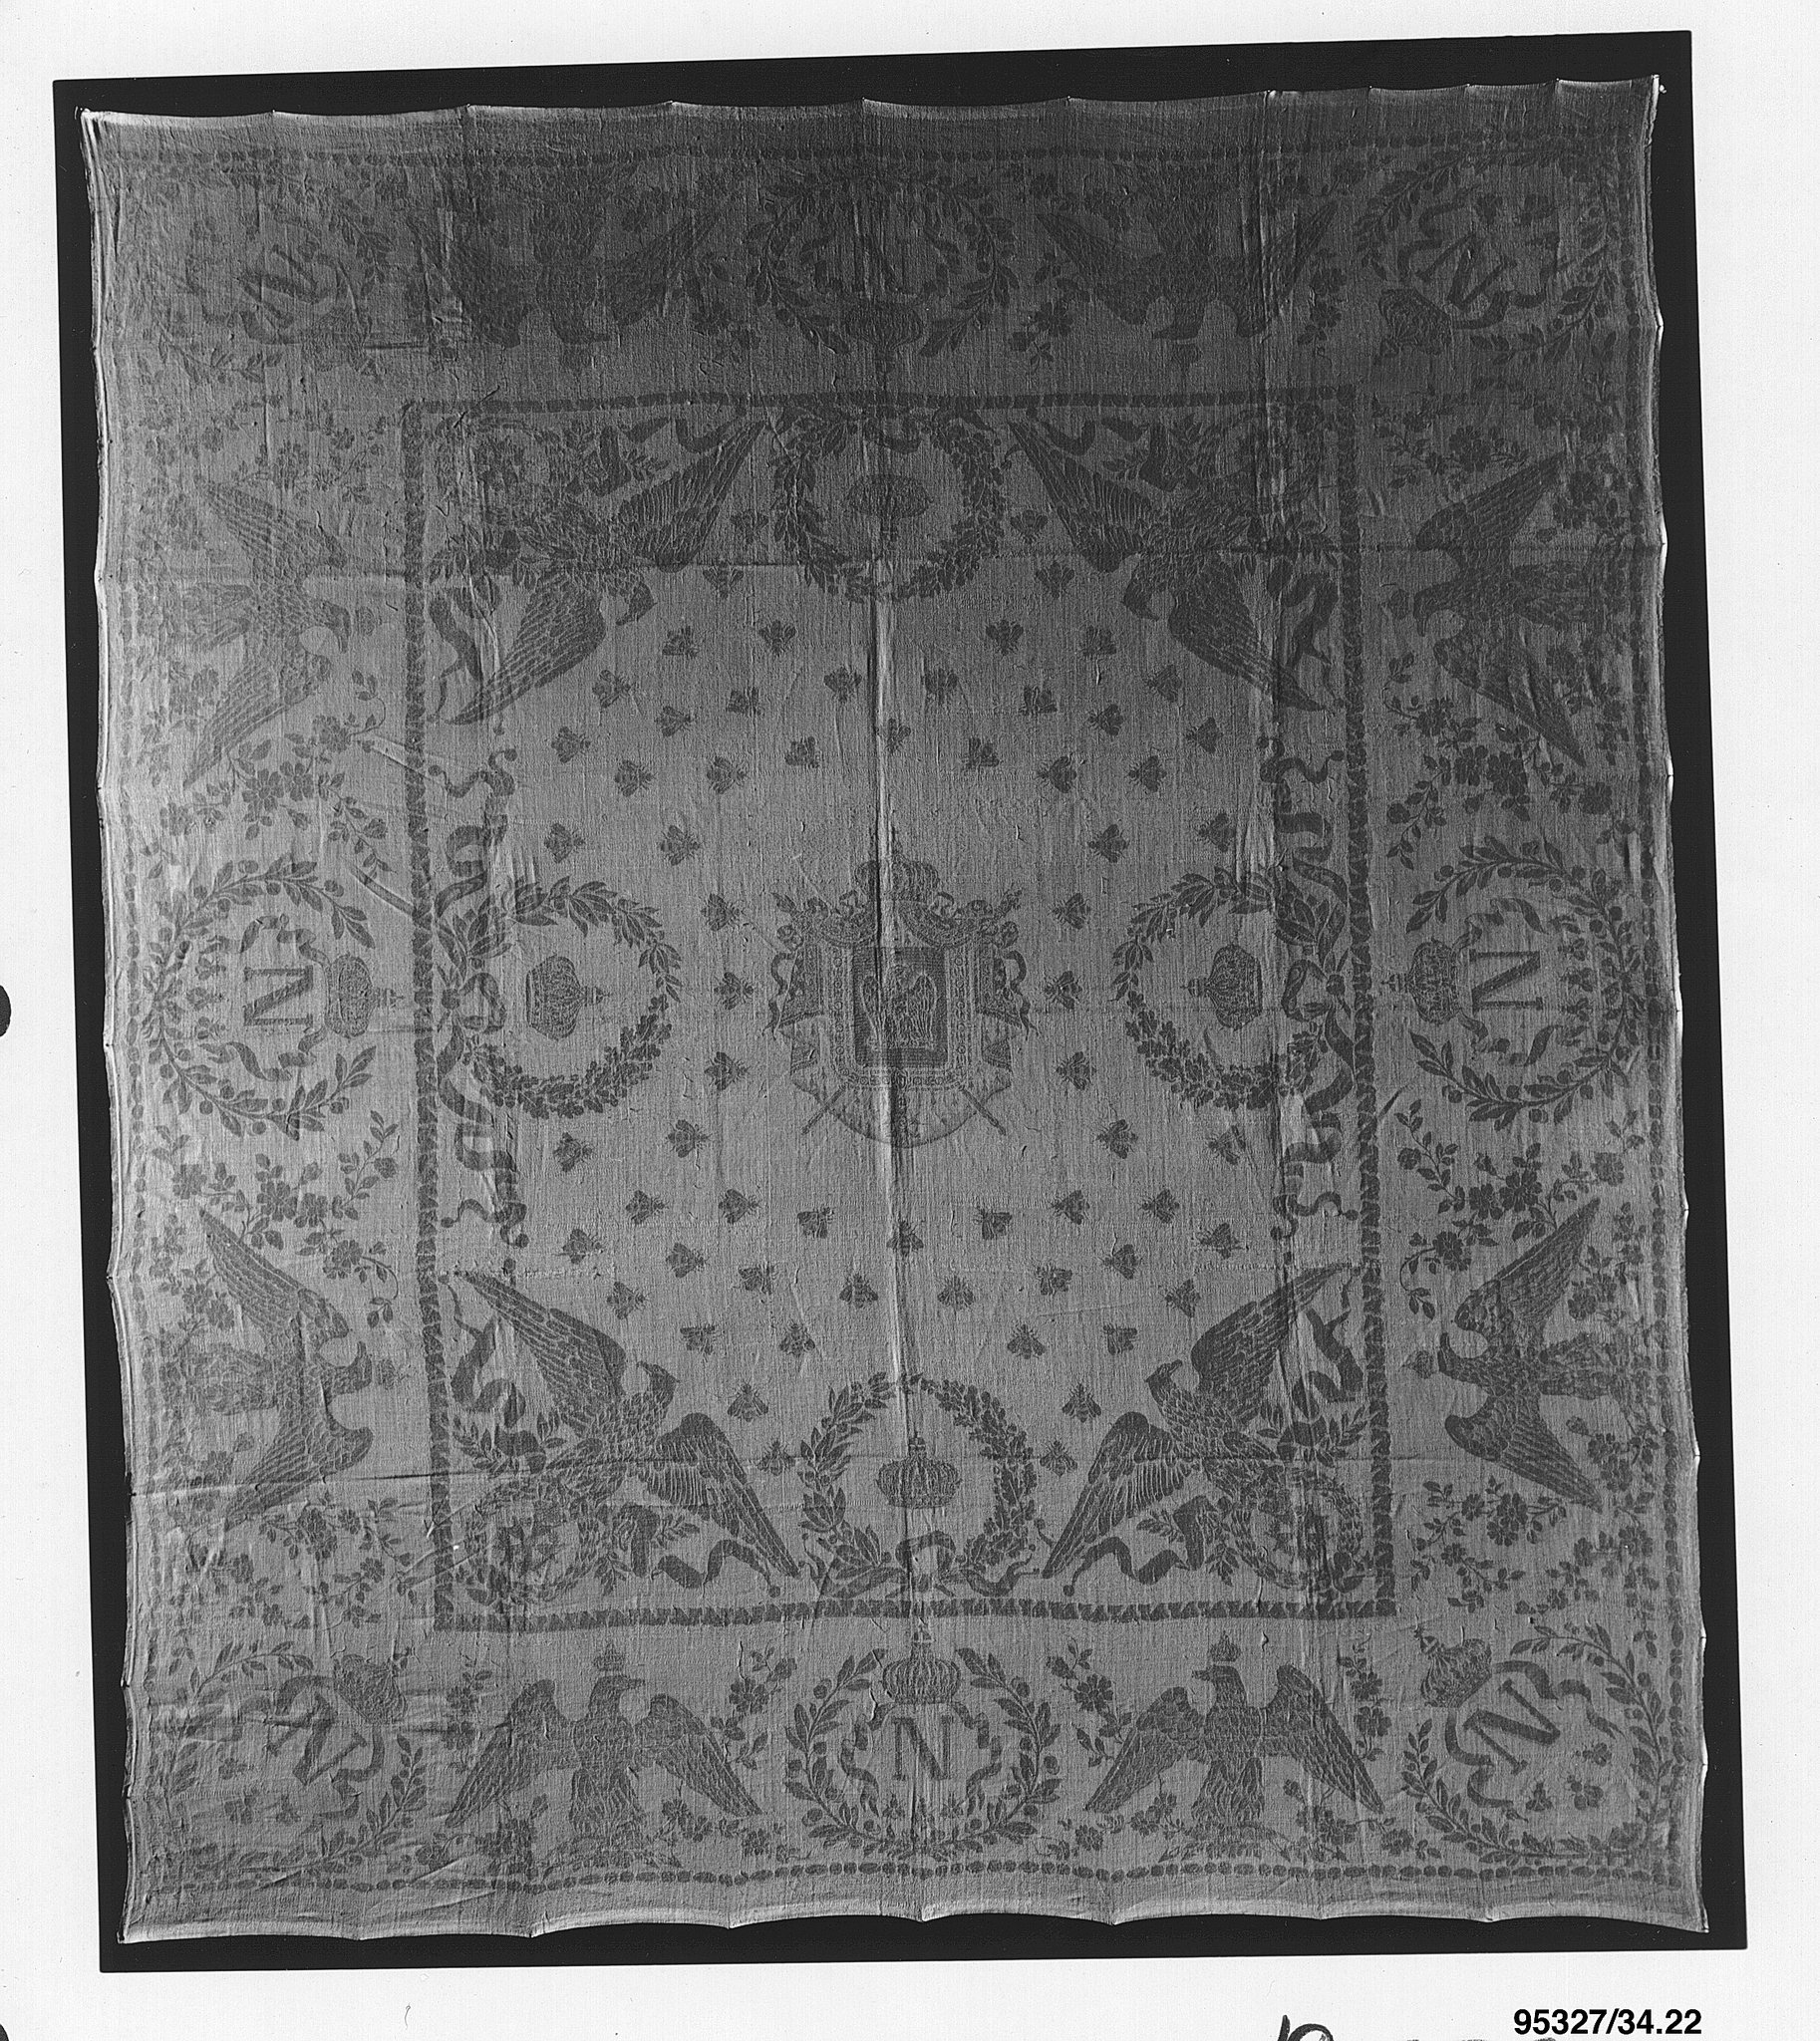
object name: napkin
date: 1852-1870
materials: linen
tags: birds,coat of arms